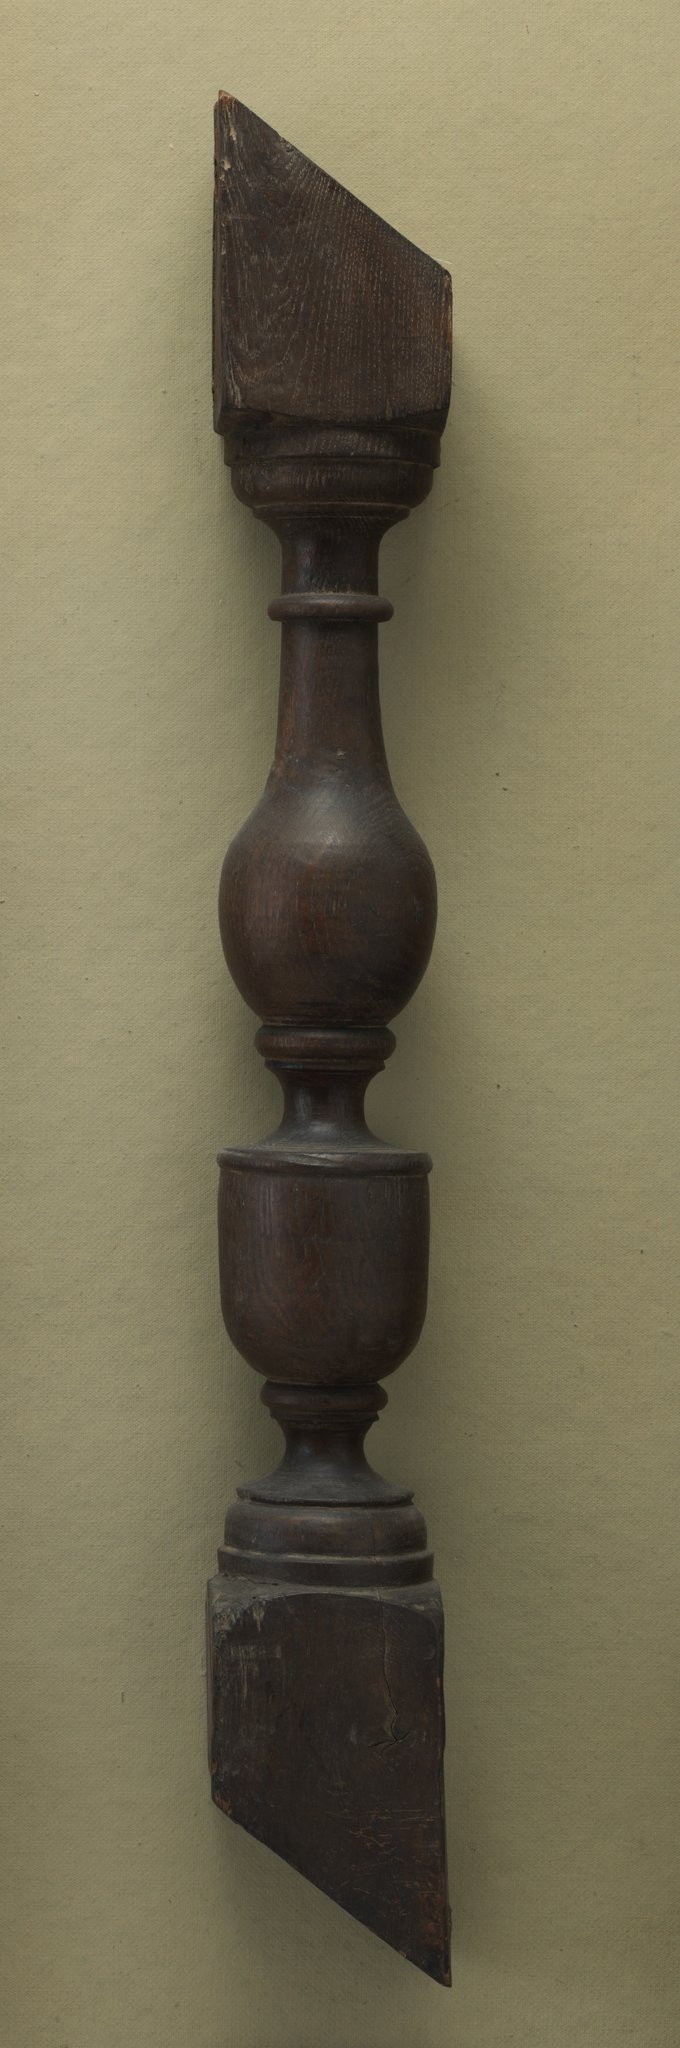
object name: baluster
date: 1651-1700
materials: wood